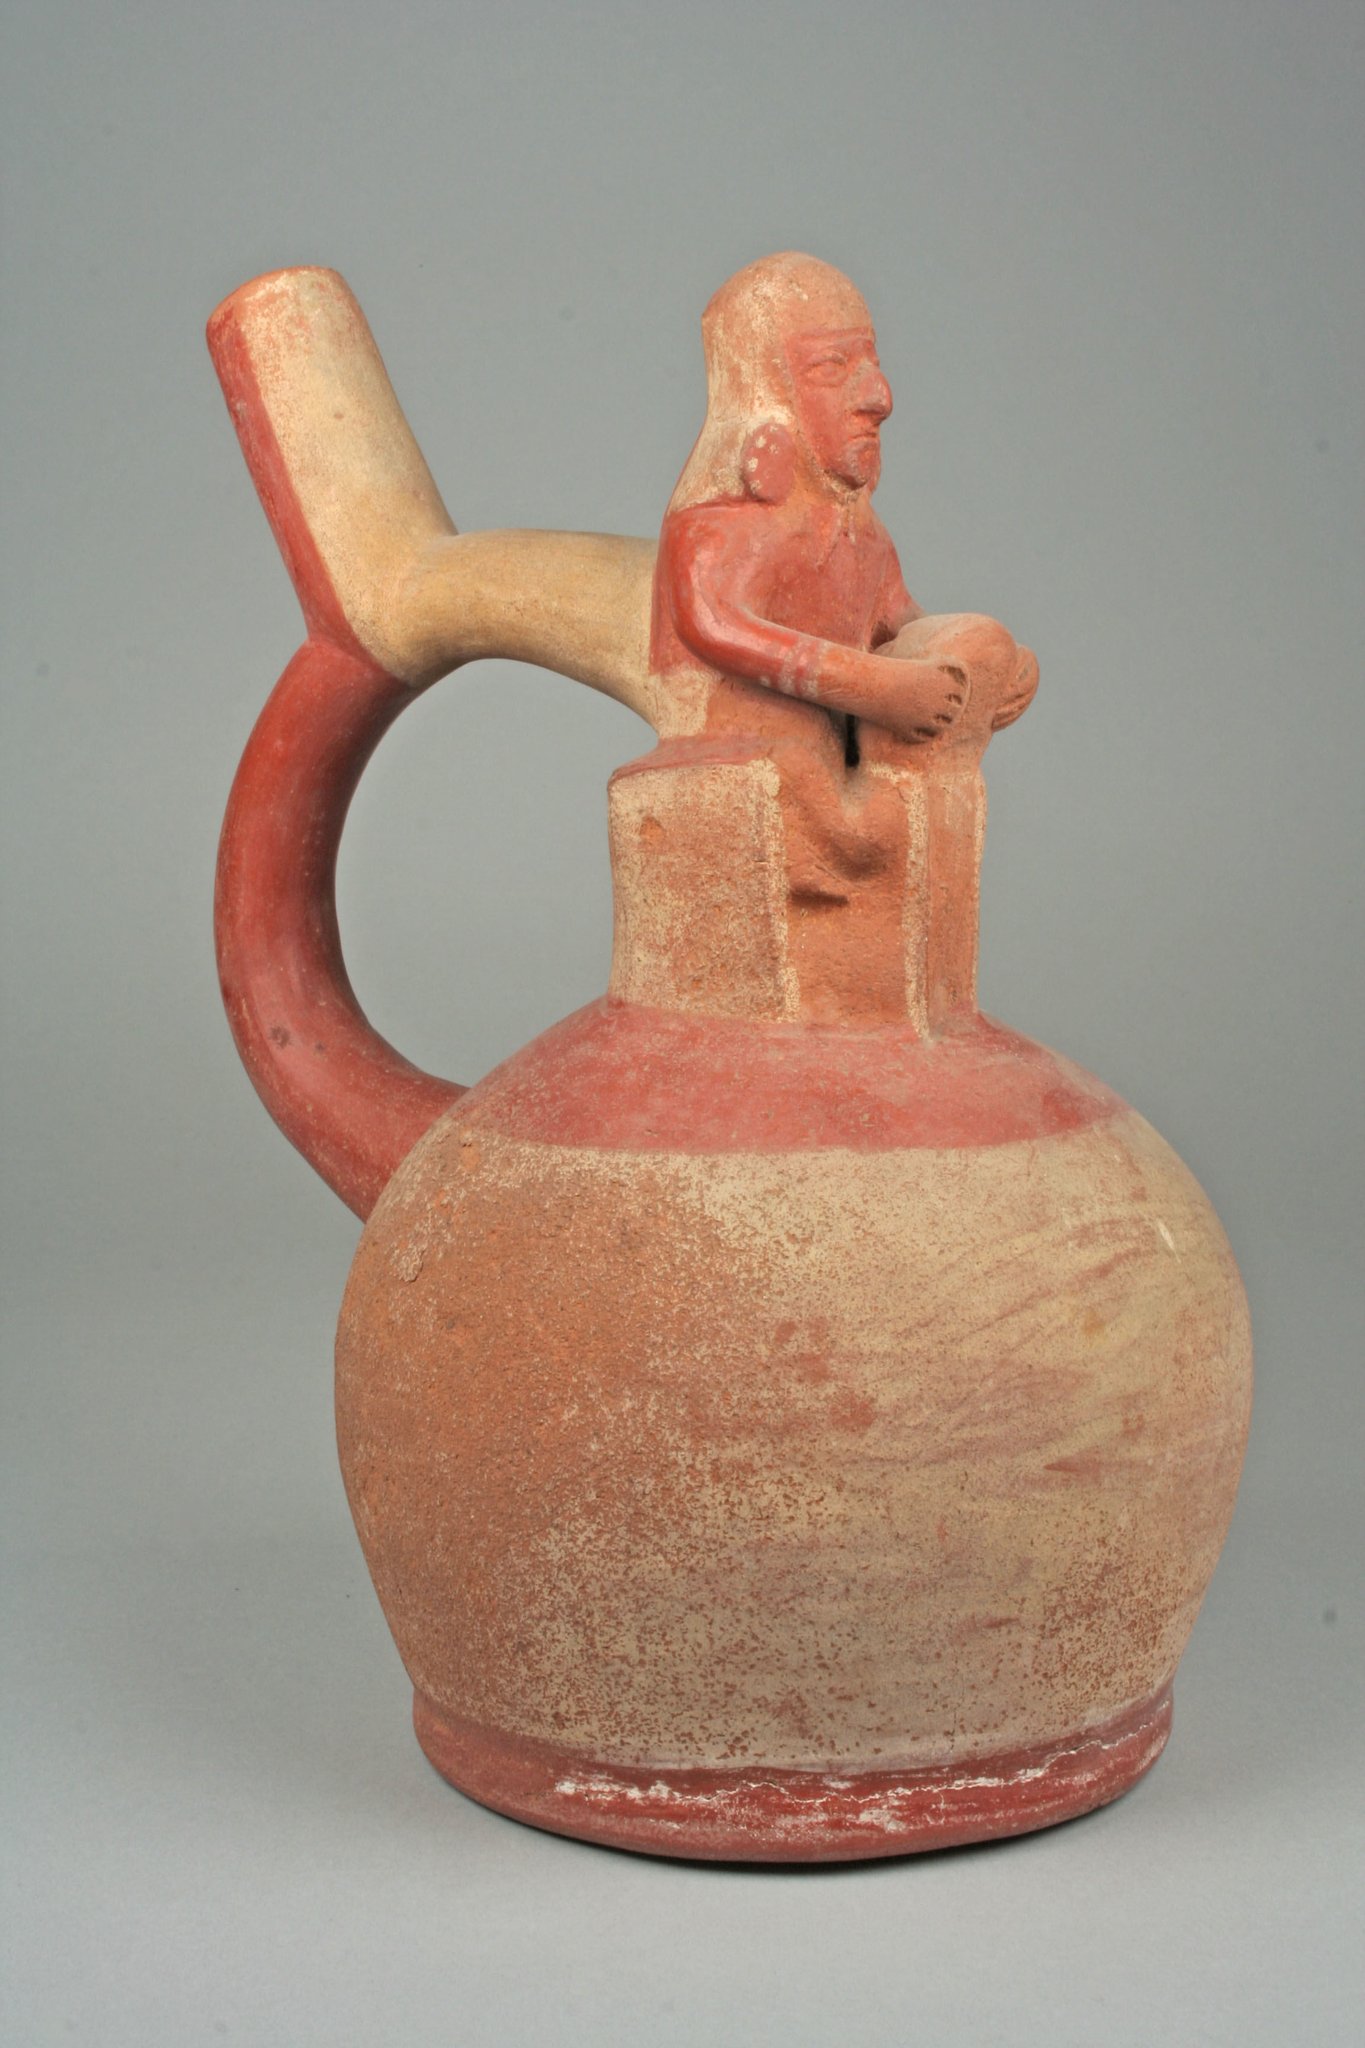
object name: bottle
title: Stirrup Spout Bottle with Couple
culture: moche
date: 301-700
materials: ceramic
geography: peru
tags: couples